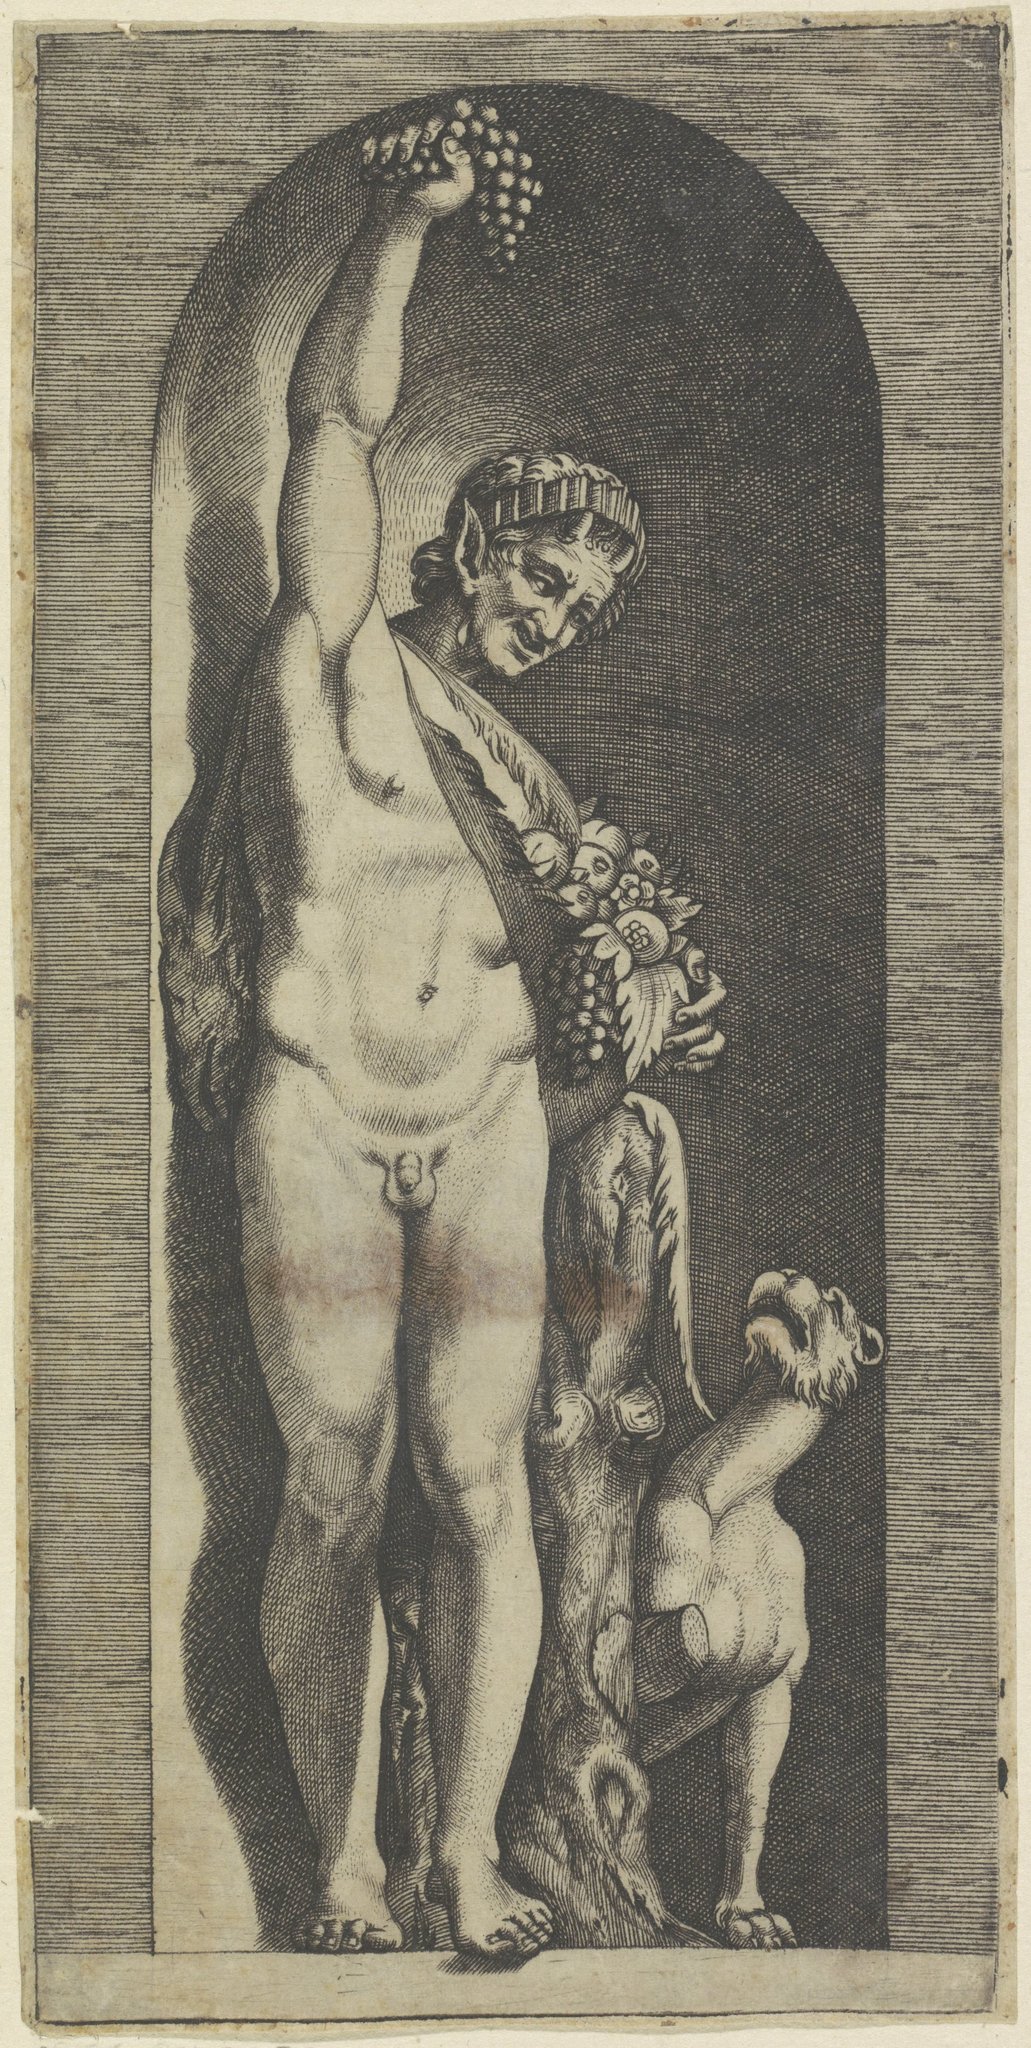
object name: print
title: Faun en tijger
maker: marco dente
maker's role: print maker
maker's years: 1486-1527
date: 1498-1532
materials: paper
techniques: engraving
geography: italy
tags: beasts of prey, predatory animals: tiger, satyrs, fauns, sileni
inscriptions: collector's mark: Lugt 12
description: Een faun, met een omgeslagen dierenvel vol fruit, samen met een tijger in een nis.